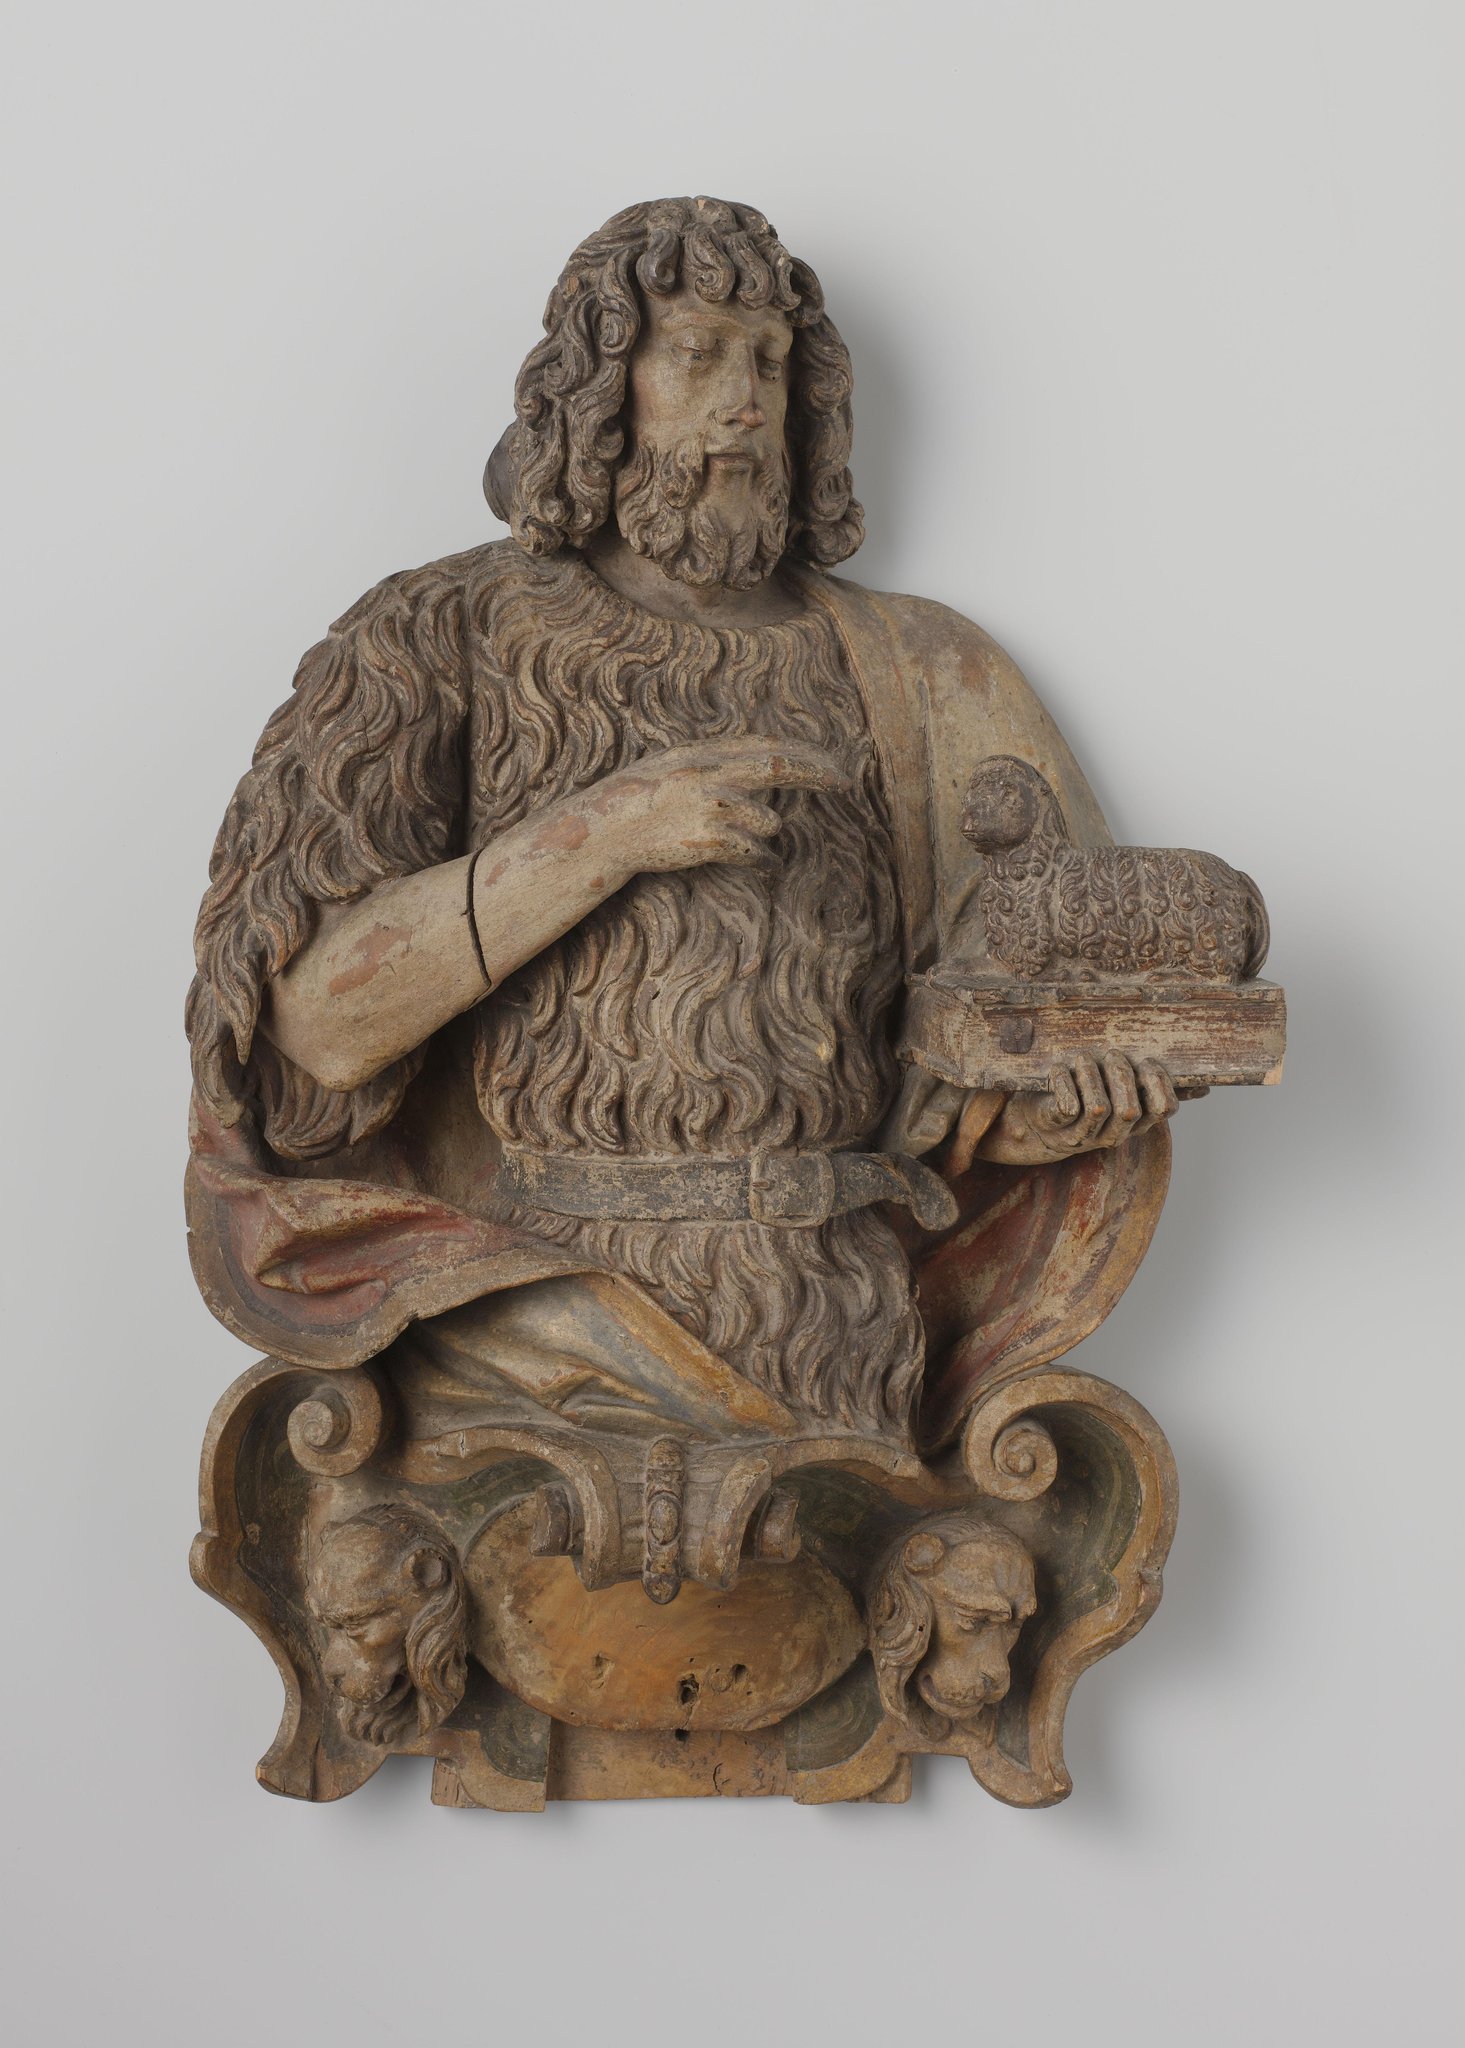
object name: sculpture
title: Demi-Figure of St John the Baptist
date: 1650-1675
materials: wood